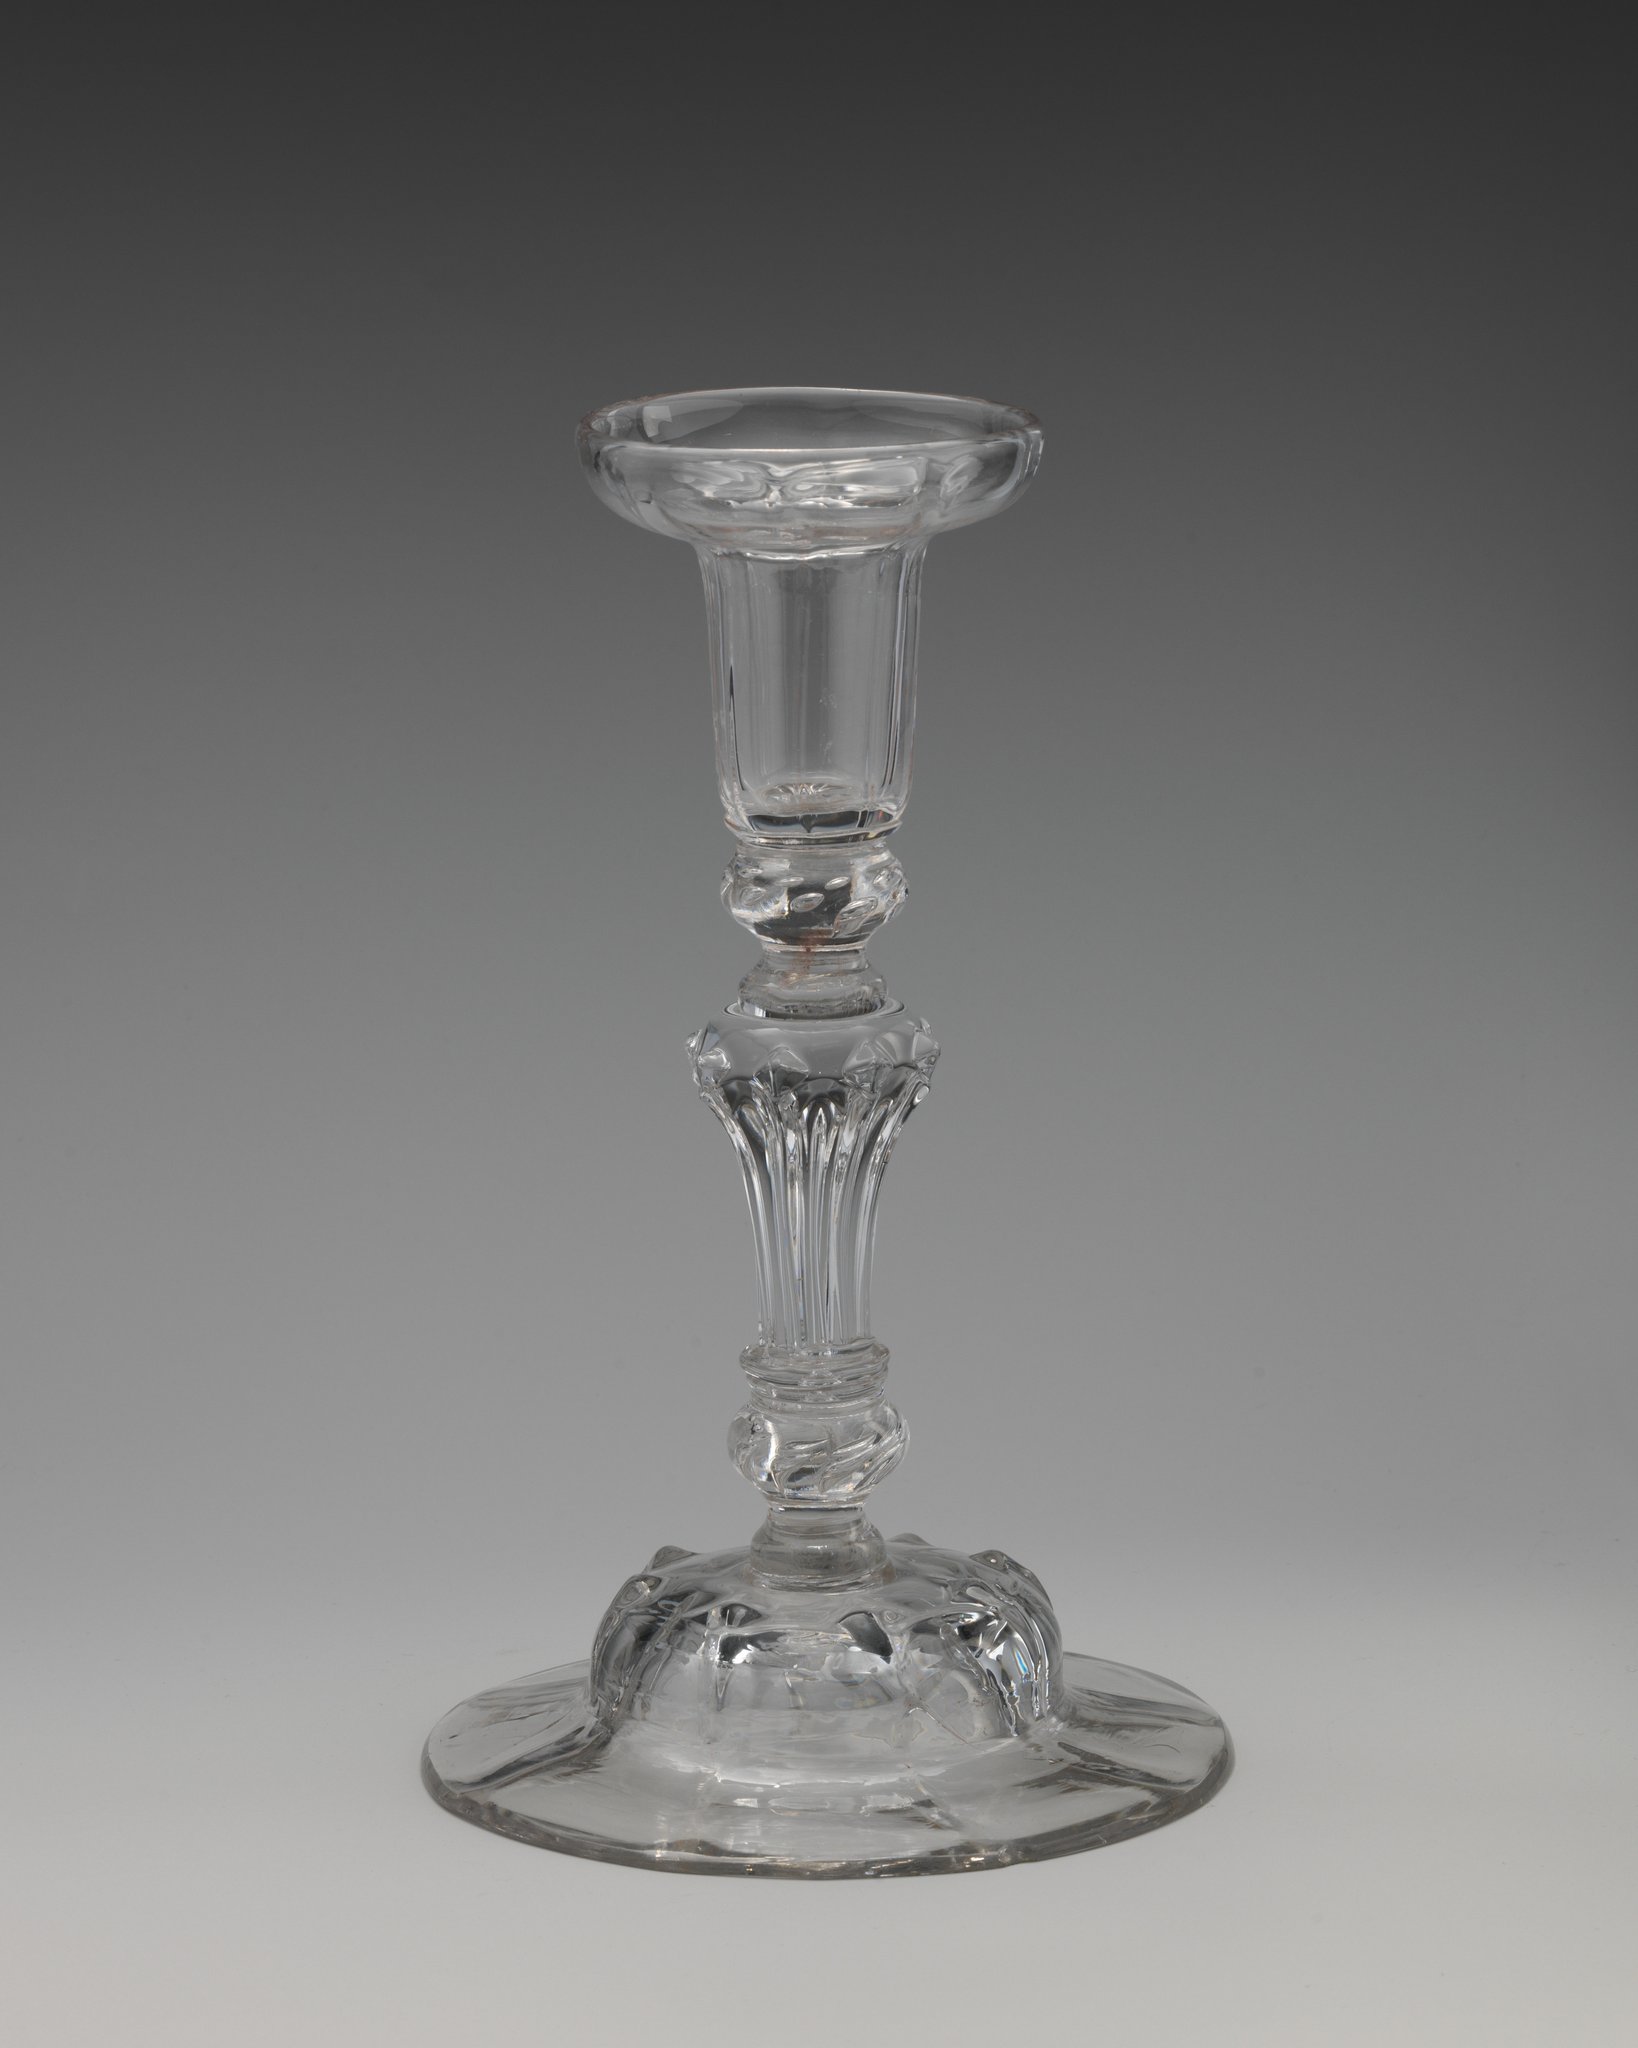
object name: candlestick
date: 1740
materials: glass